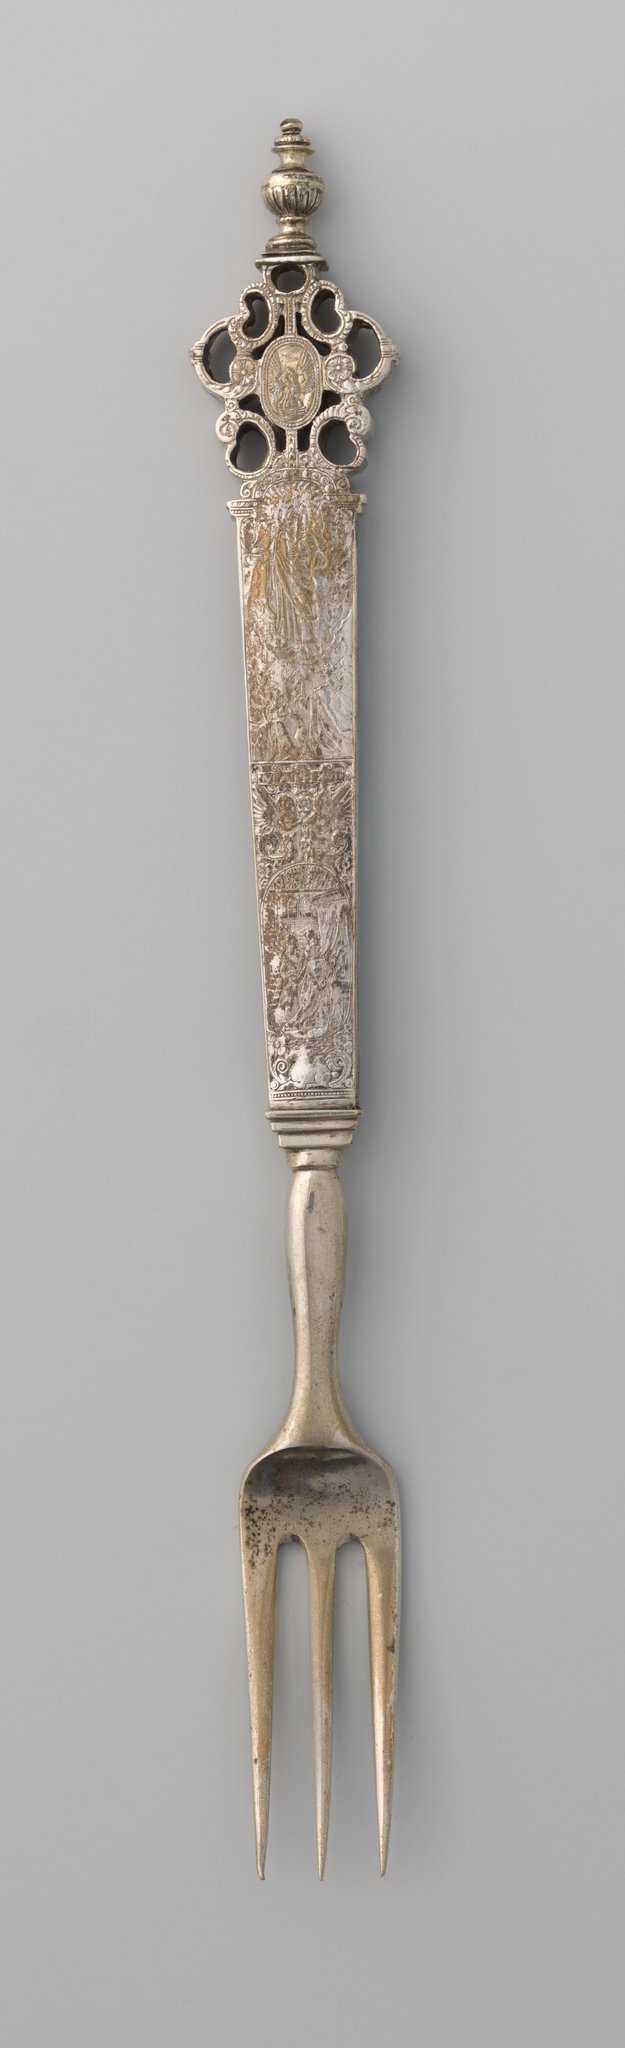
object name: fork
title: Vork van zilver met geheel gegraveerde steel. Top met uitgesneden ornament. Geheel eindigt in vorm van een vaas.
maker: johann theodor de bry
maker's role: print maker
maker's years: 1561-1623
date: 1575-1600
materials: silver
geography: southern netherlands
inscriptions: mark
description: Two forks. Silver. Netherlands, c. 1575-1600.